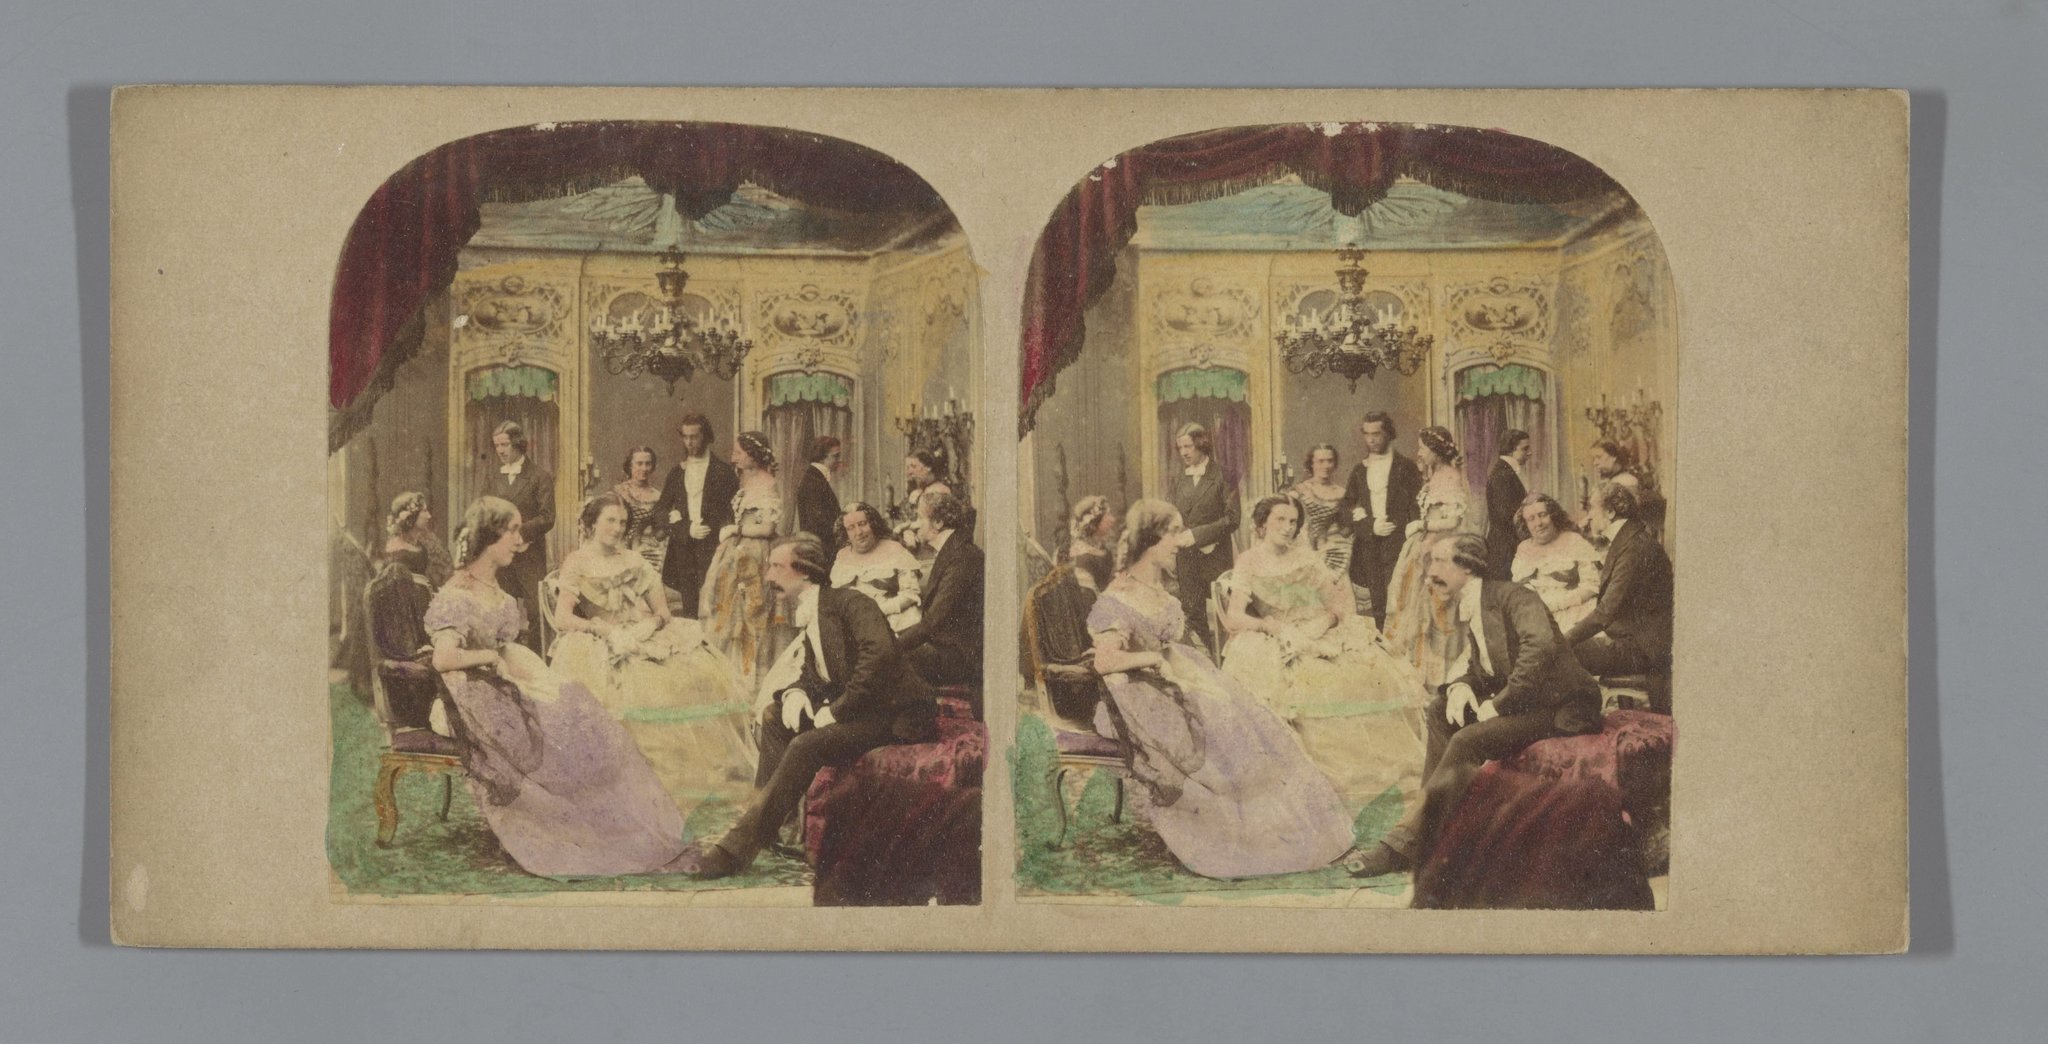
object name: stereograph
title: Salonscène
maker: Anonymous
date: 1852-1863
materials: cardboard, paper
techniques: albumen print, hand coloring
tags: drawing-room, 'salon'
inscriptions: inscription: ‘foto zelfde decor in Gernsheim History of photography/ folio 145: unknown photographer Ballroom scene c 1855’